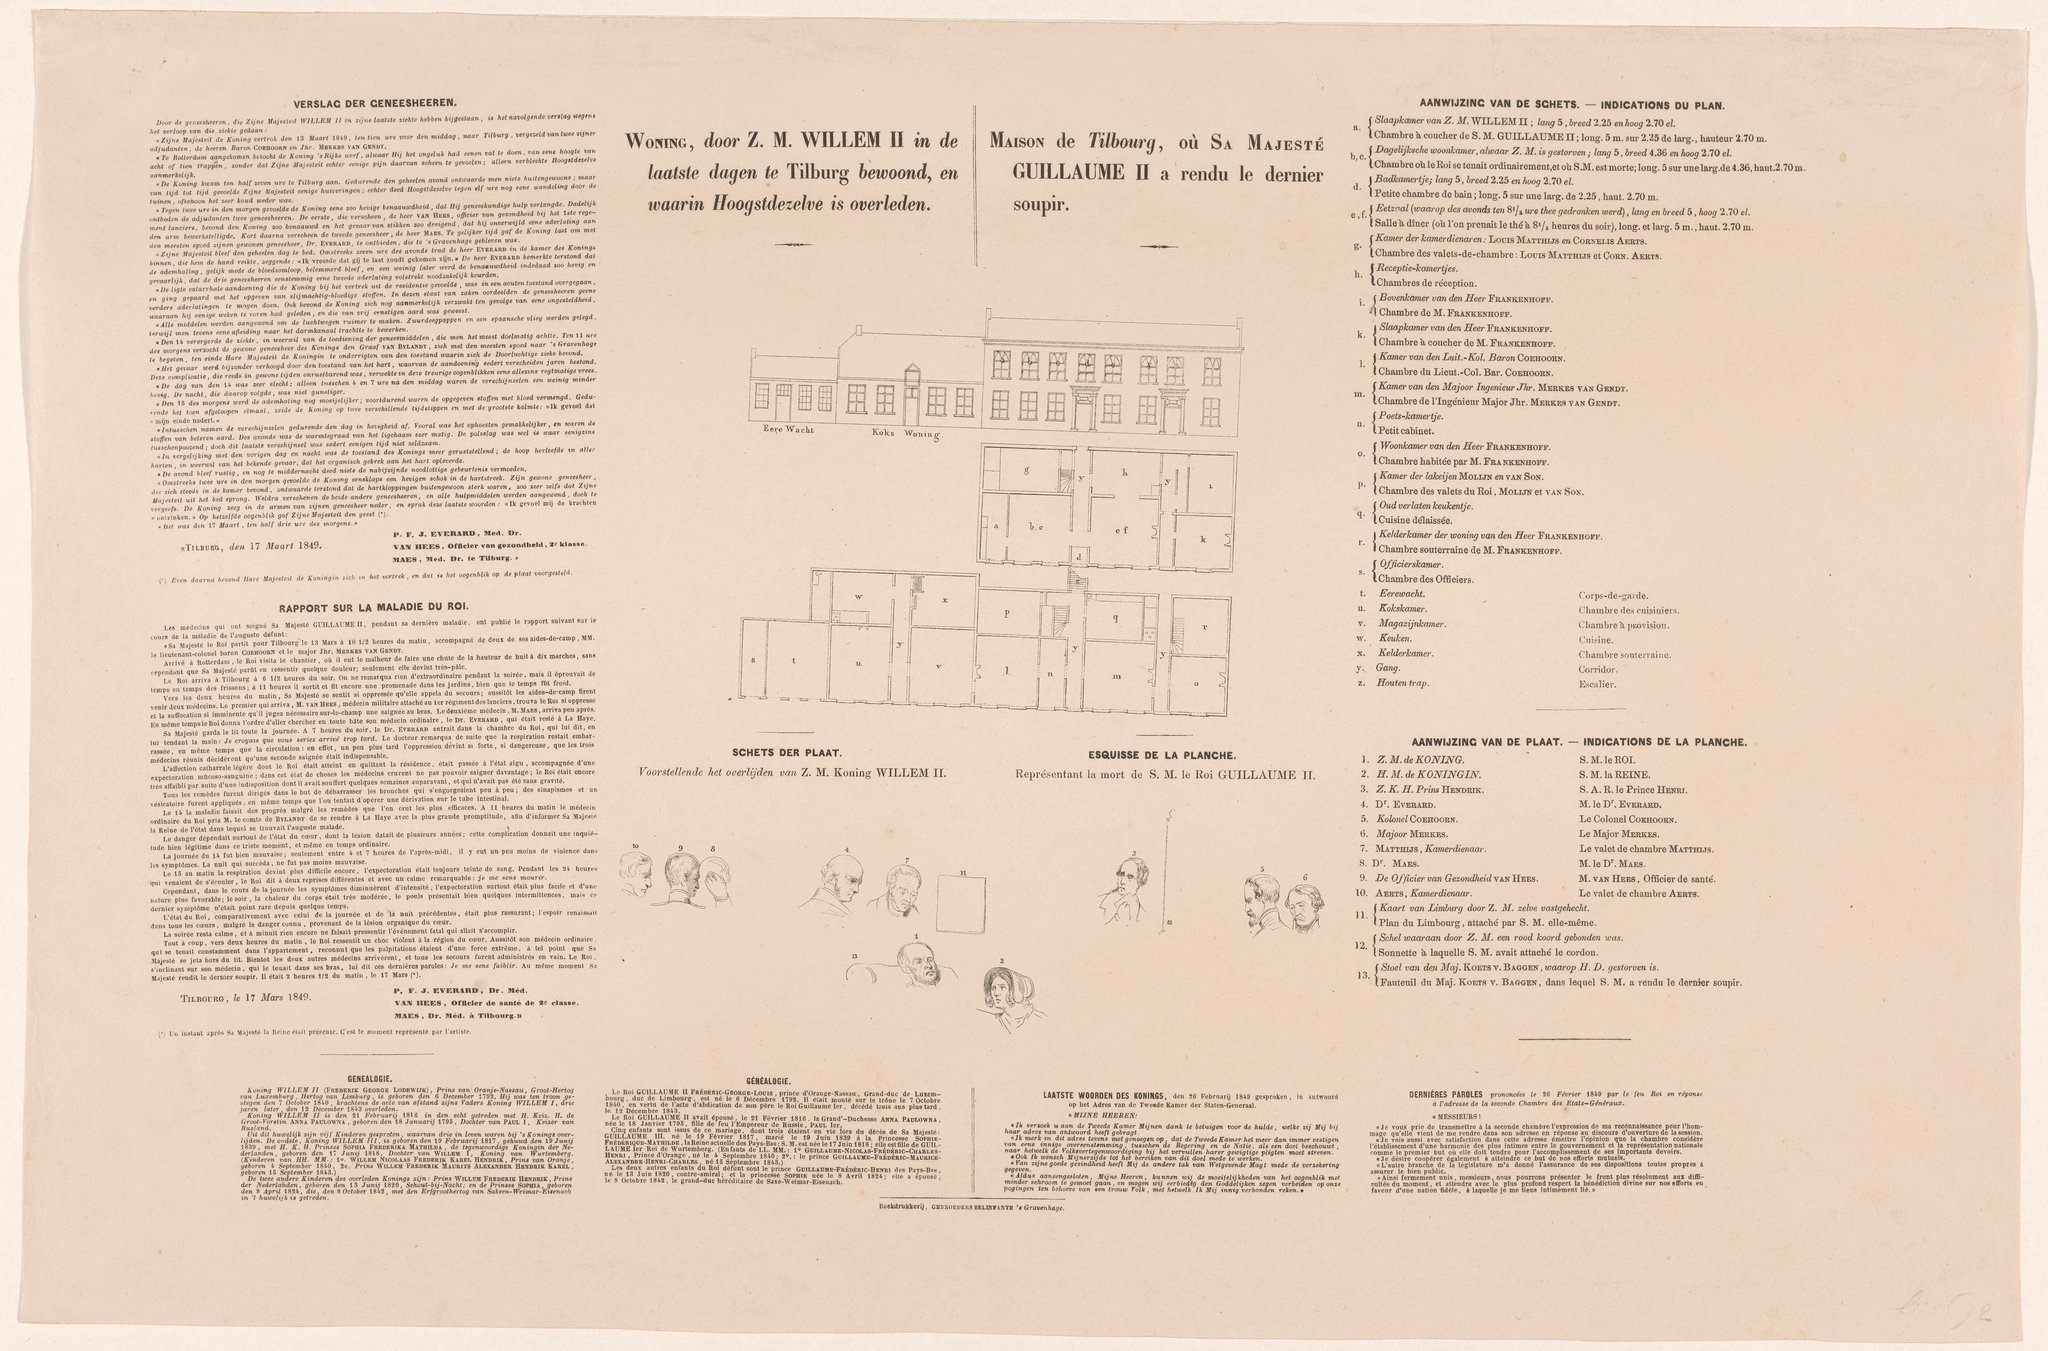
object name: print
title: Verklaring bij de prent van het overlijden van koning Willem II, 1849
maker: Anonymous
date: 1849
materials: paper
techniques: lithograph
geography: netherlands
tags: william ii of the netherlands, deathbed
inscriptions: collector's mark: Lugt 2228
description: Aparte verklaring behorende bij de prent van het overlijden van koning Willem II in Tilburg op 17 maart 1849. Centraal een plattegrond van de woning van de koning te Tilburg, daaronder een sleutel met de namen van de voorgestelde personen. Links, rechts en onderaan het verslag van de artsen, de genealogie en de laatste woorden van de koning en de legenda's a-z en 1-13.